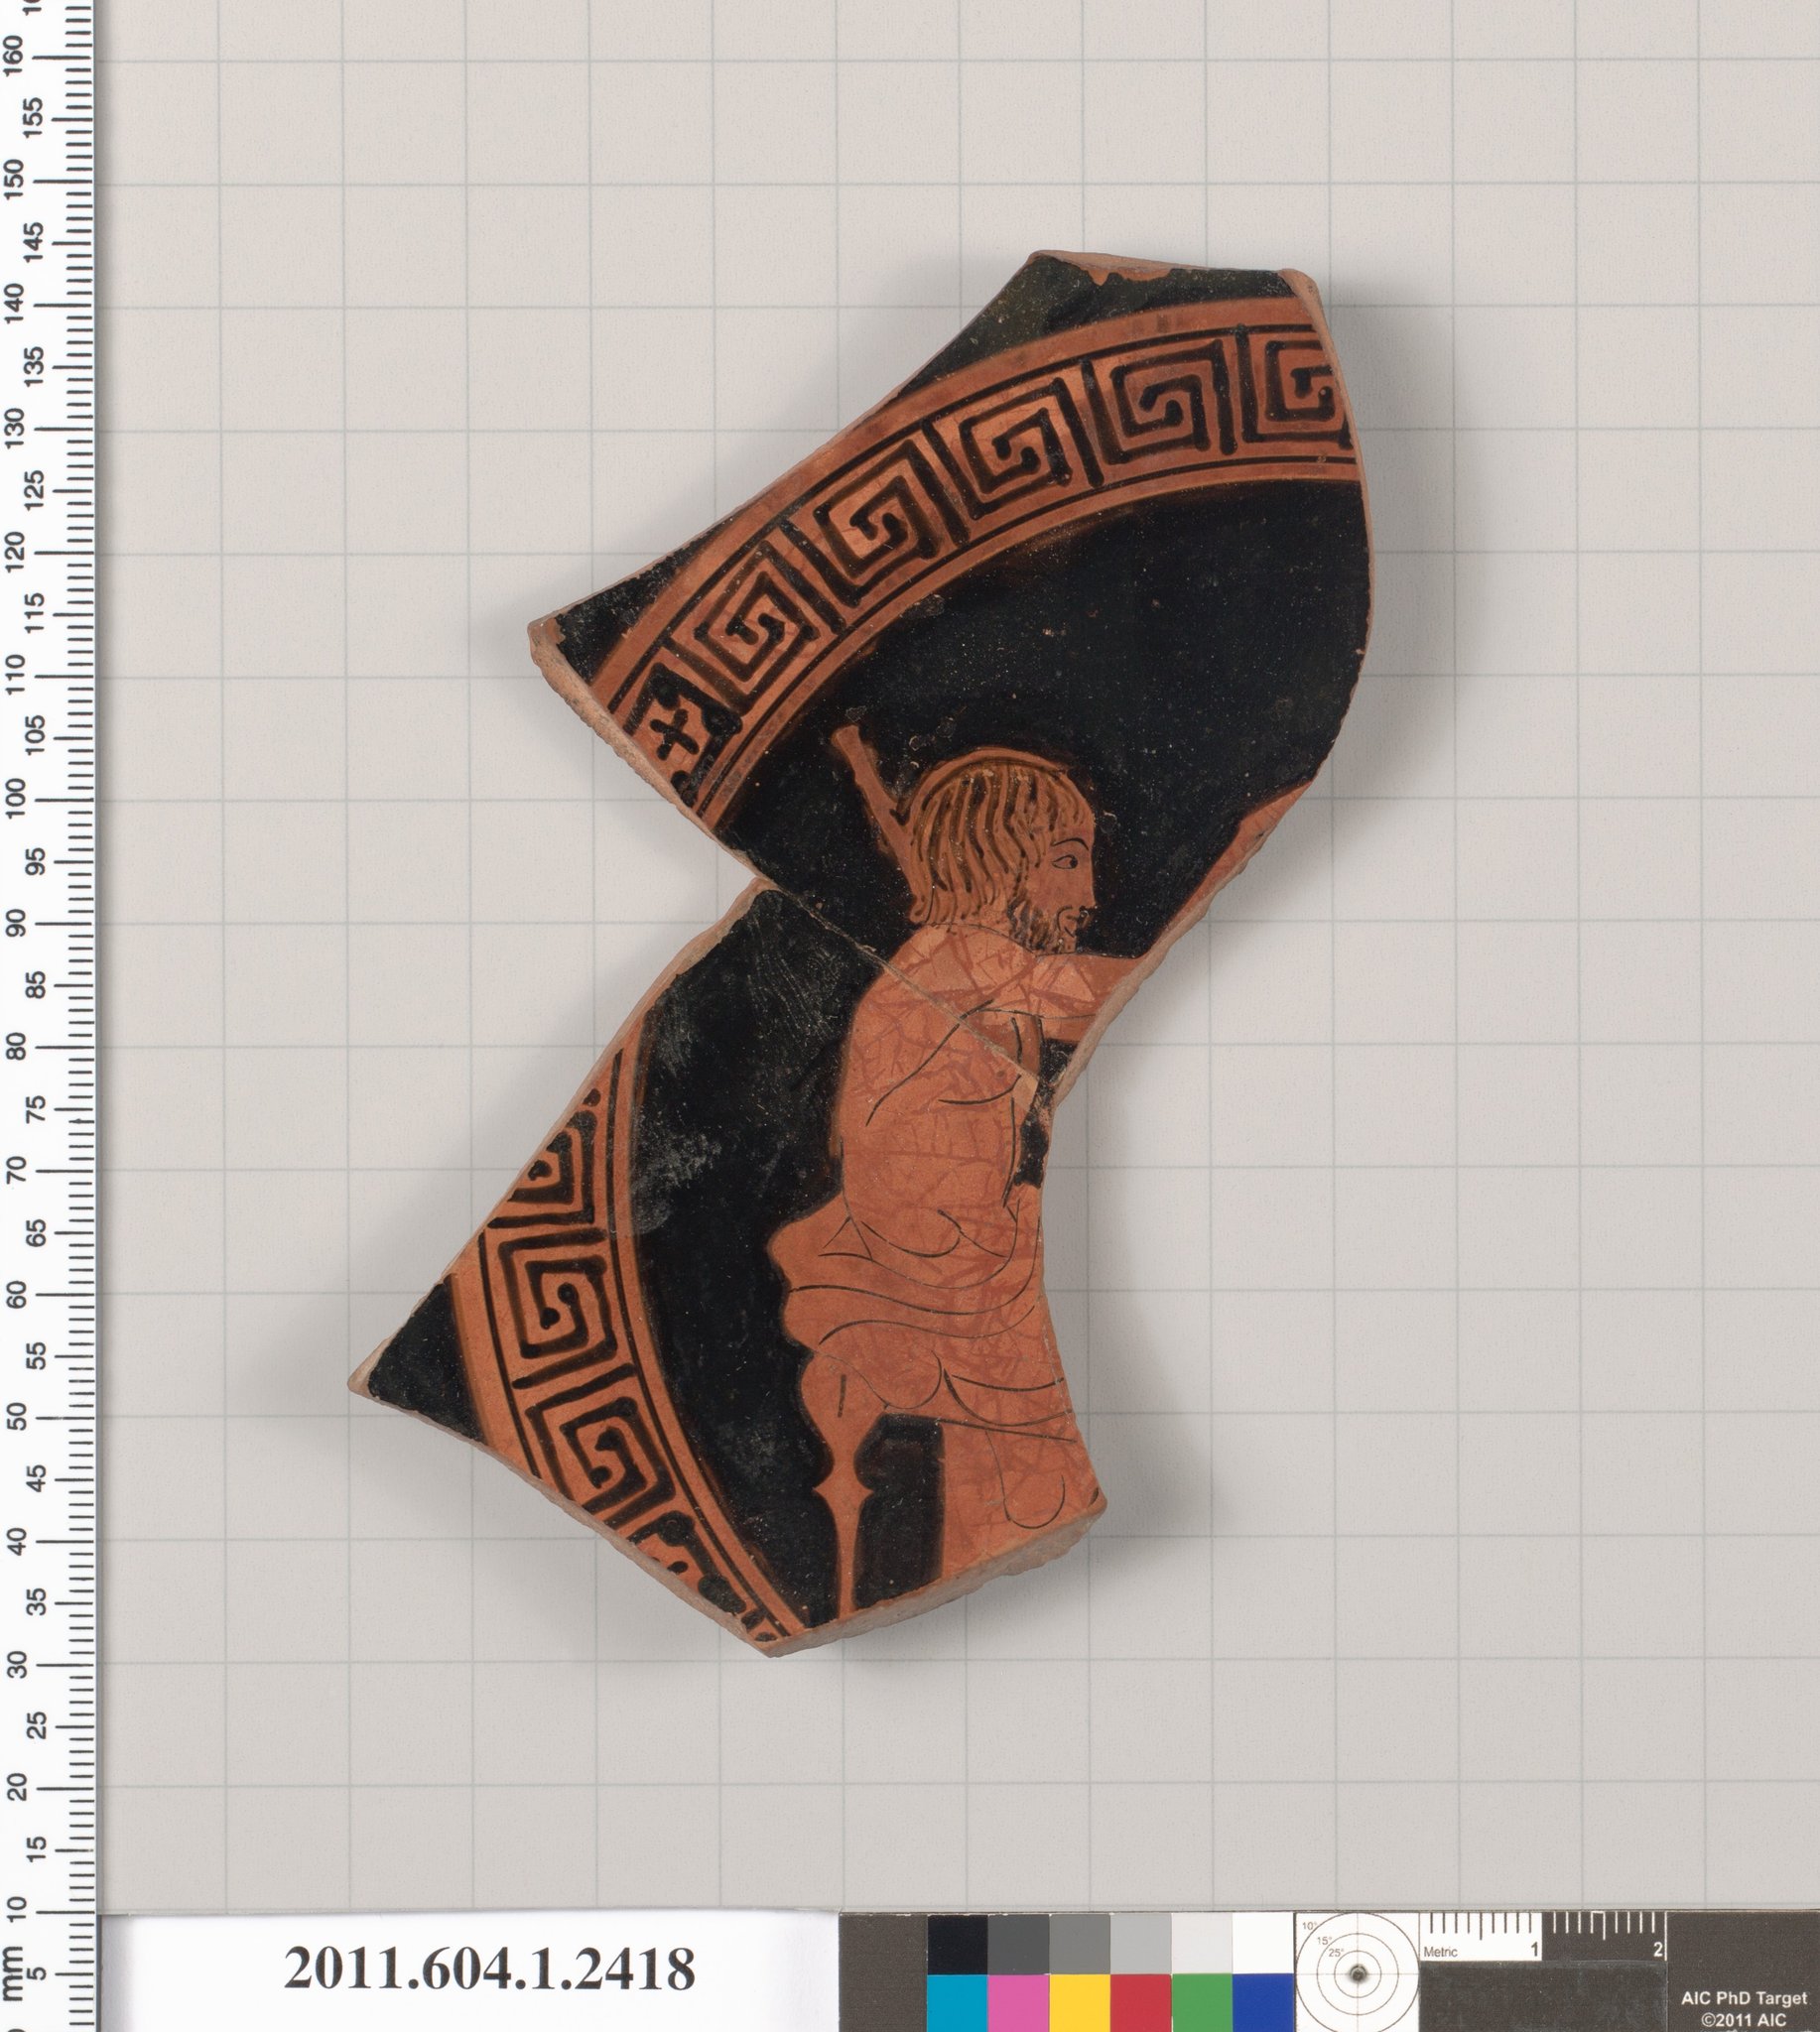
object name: kylix fragment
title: Terracotta fragment of a kylix (drinking cup)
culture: greek, attic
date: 460-450 BCE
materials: terracotta